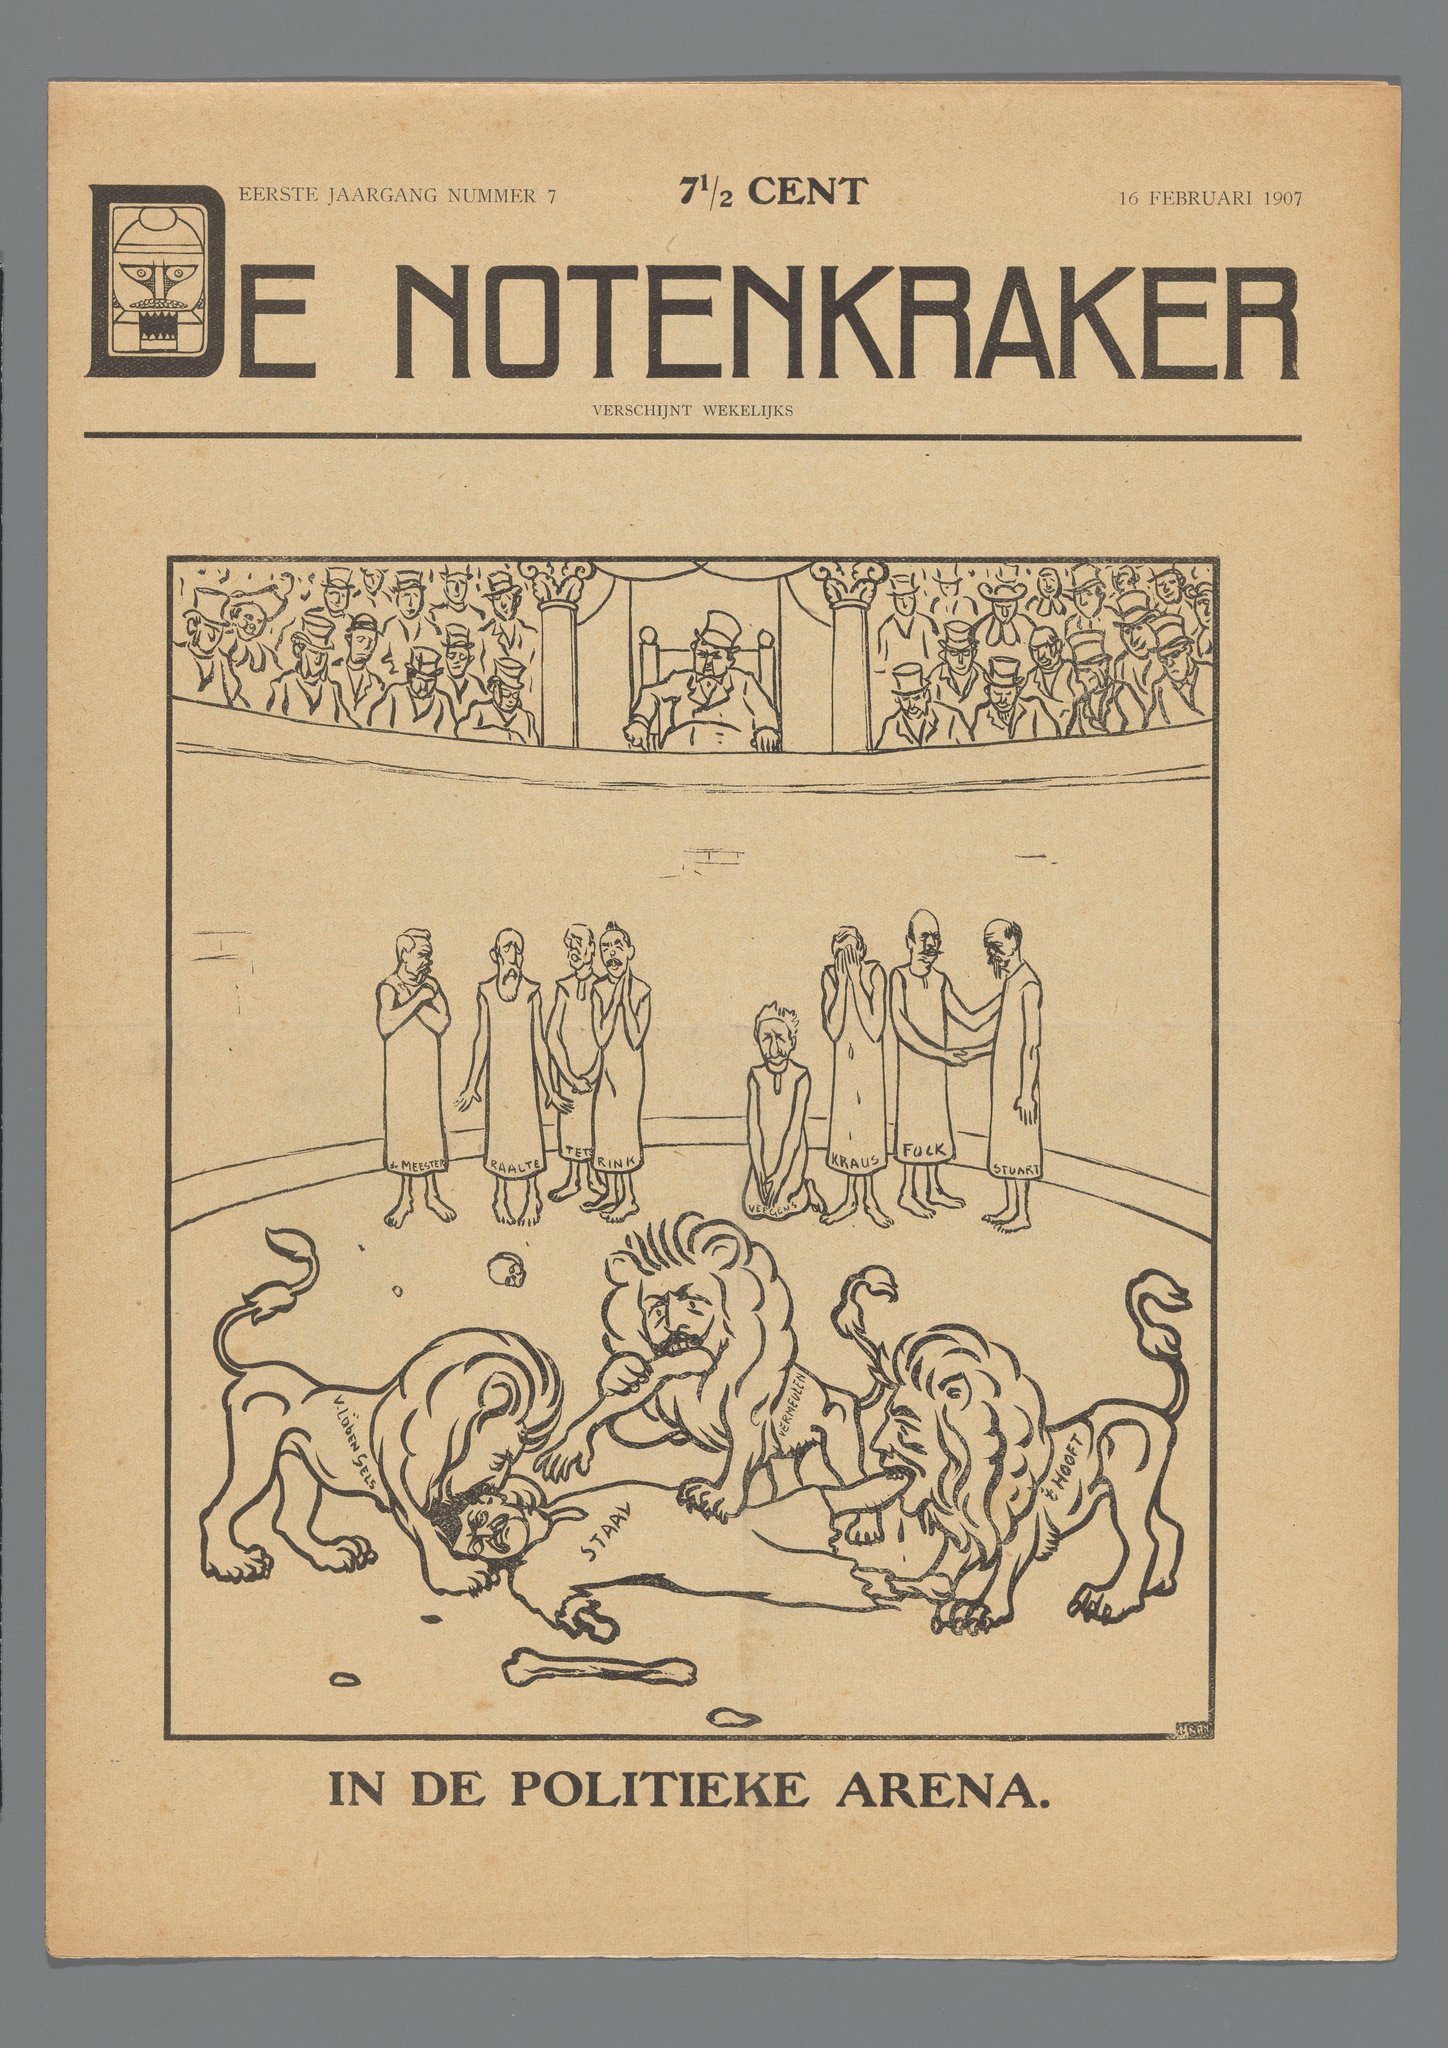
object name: print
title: De Notenkraker, 16 februari 1907 / In de politieke arena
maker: albert hahn (i)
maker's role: draughtsman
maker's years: 1877-1918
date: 1907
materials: paper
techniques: lithograph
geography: amsterdam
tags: the hague, abraham kuyper, violent death by throwing to the wild animals, emperor, beasts of prey, predatory animals: lion, political caricatures and satires, netherlands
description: Aflevering van het satirische tijdschrift De Notenkraker van 16 februari 1907, eerste jaargang, nummer 7. Omslag met illustratie met Abraham Kuyper die als Romeinse keizer toeziet hoe zijn politieke rivalen als christenen in de arena door de leeuwen worden verslonden. Onderdeel van een volledige eerste jaargang (1907). Elk nummer bevat 8 bladzijden, deels nog niet losgesneden, met op de voorzijde steeds een spotprent van Albert Hahn, op de overige pagina's prenten van Hahn steeds tussen de tekst. In de letter 'D' van de titel is een kop van een zgn. notenkraker afgebeeld.